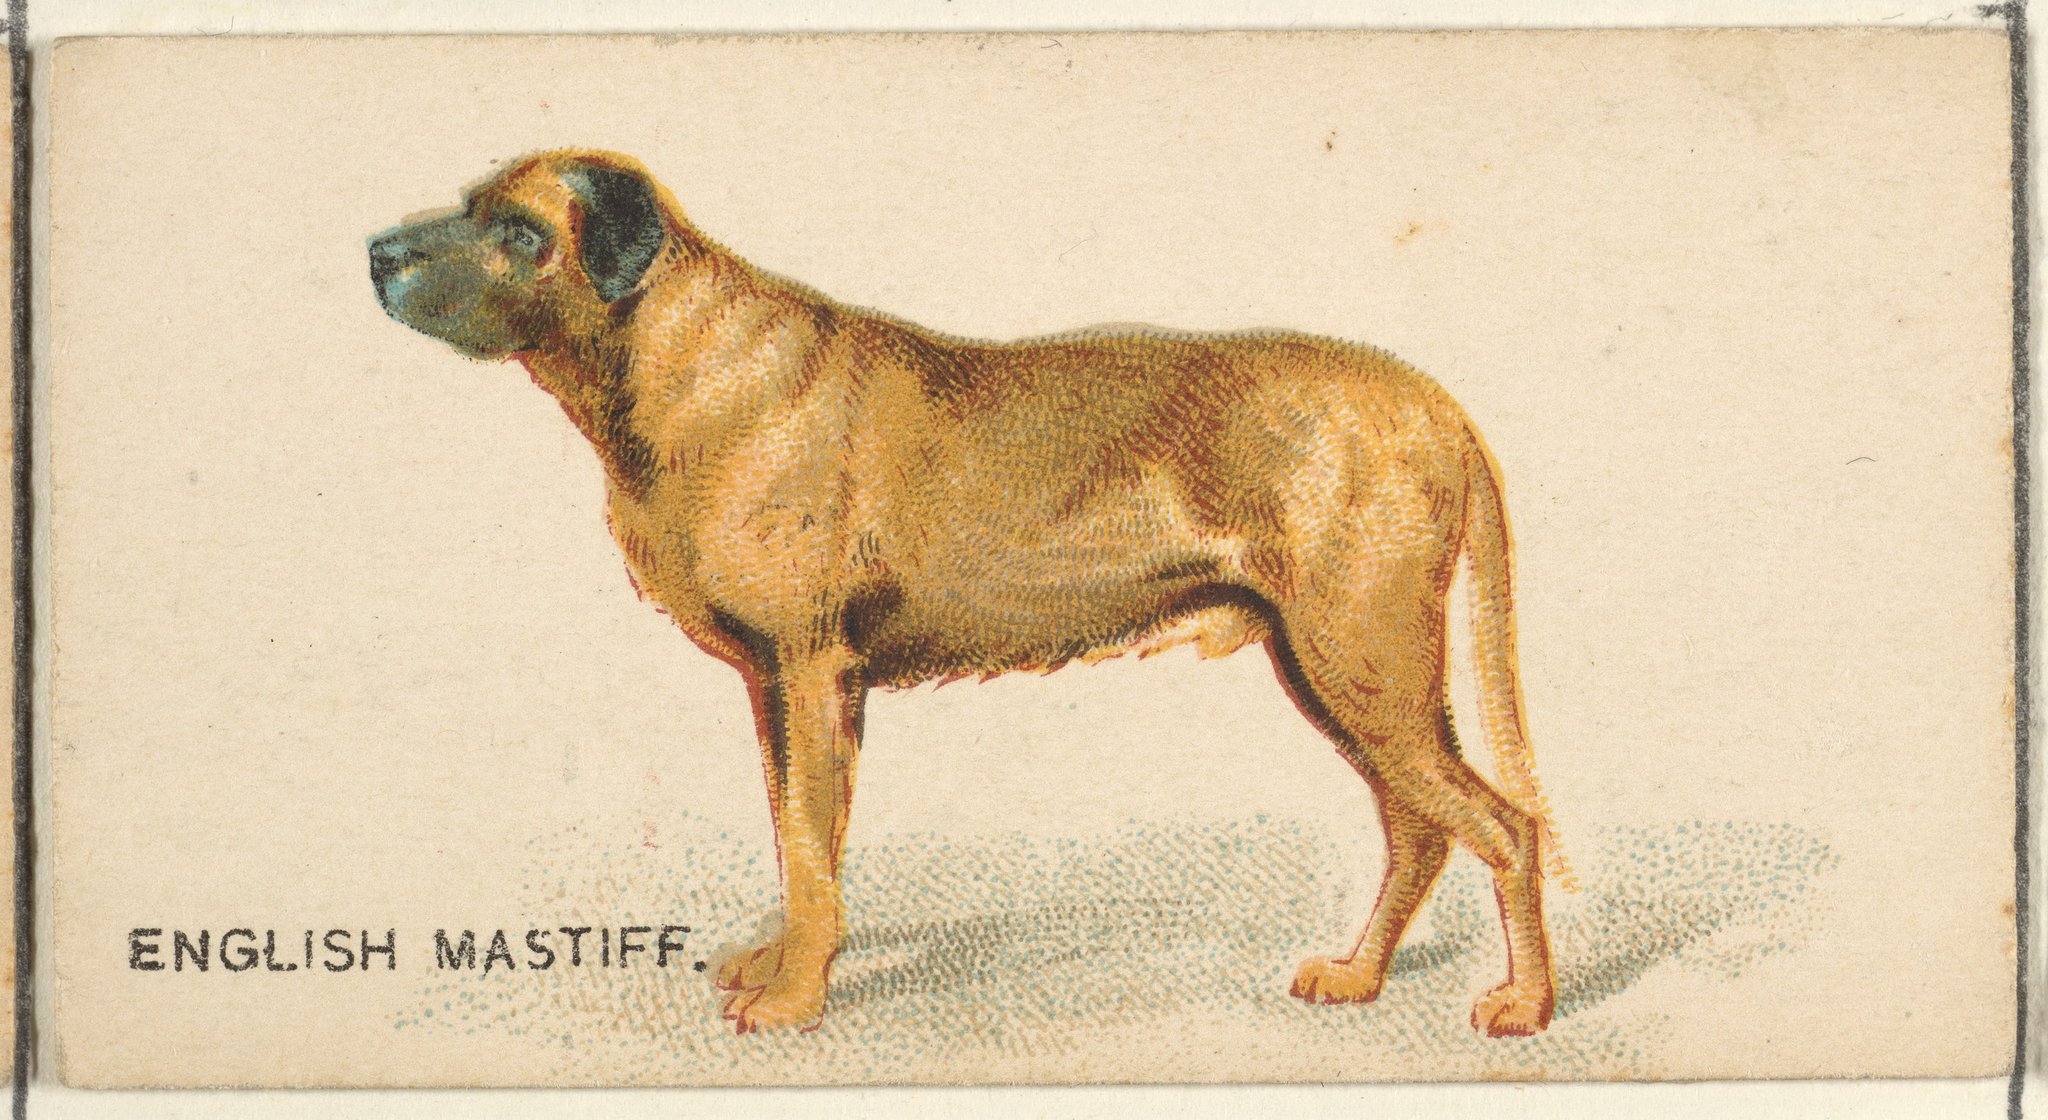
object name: print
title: English Mastiff, from the Dogs of the World series for Old Judge Cigarettes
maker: goodwin & company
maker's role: publisher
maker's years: 1850-1950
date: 1890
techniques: color lithograph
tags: dogs